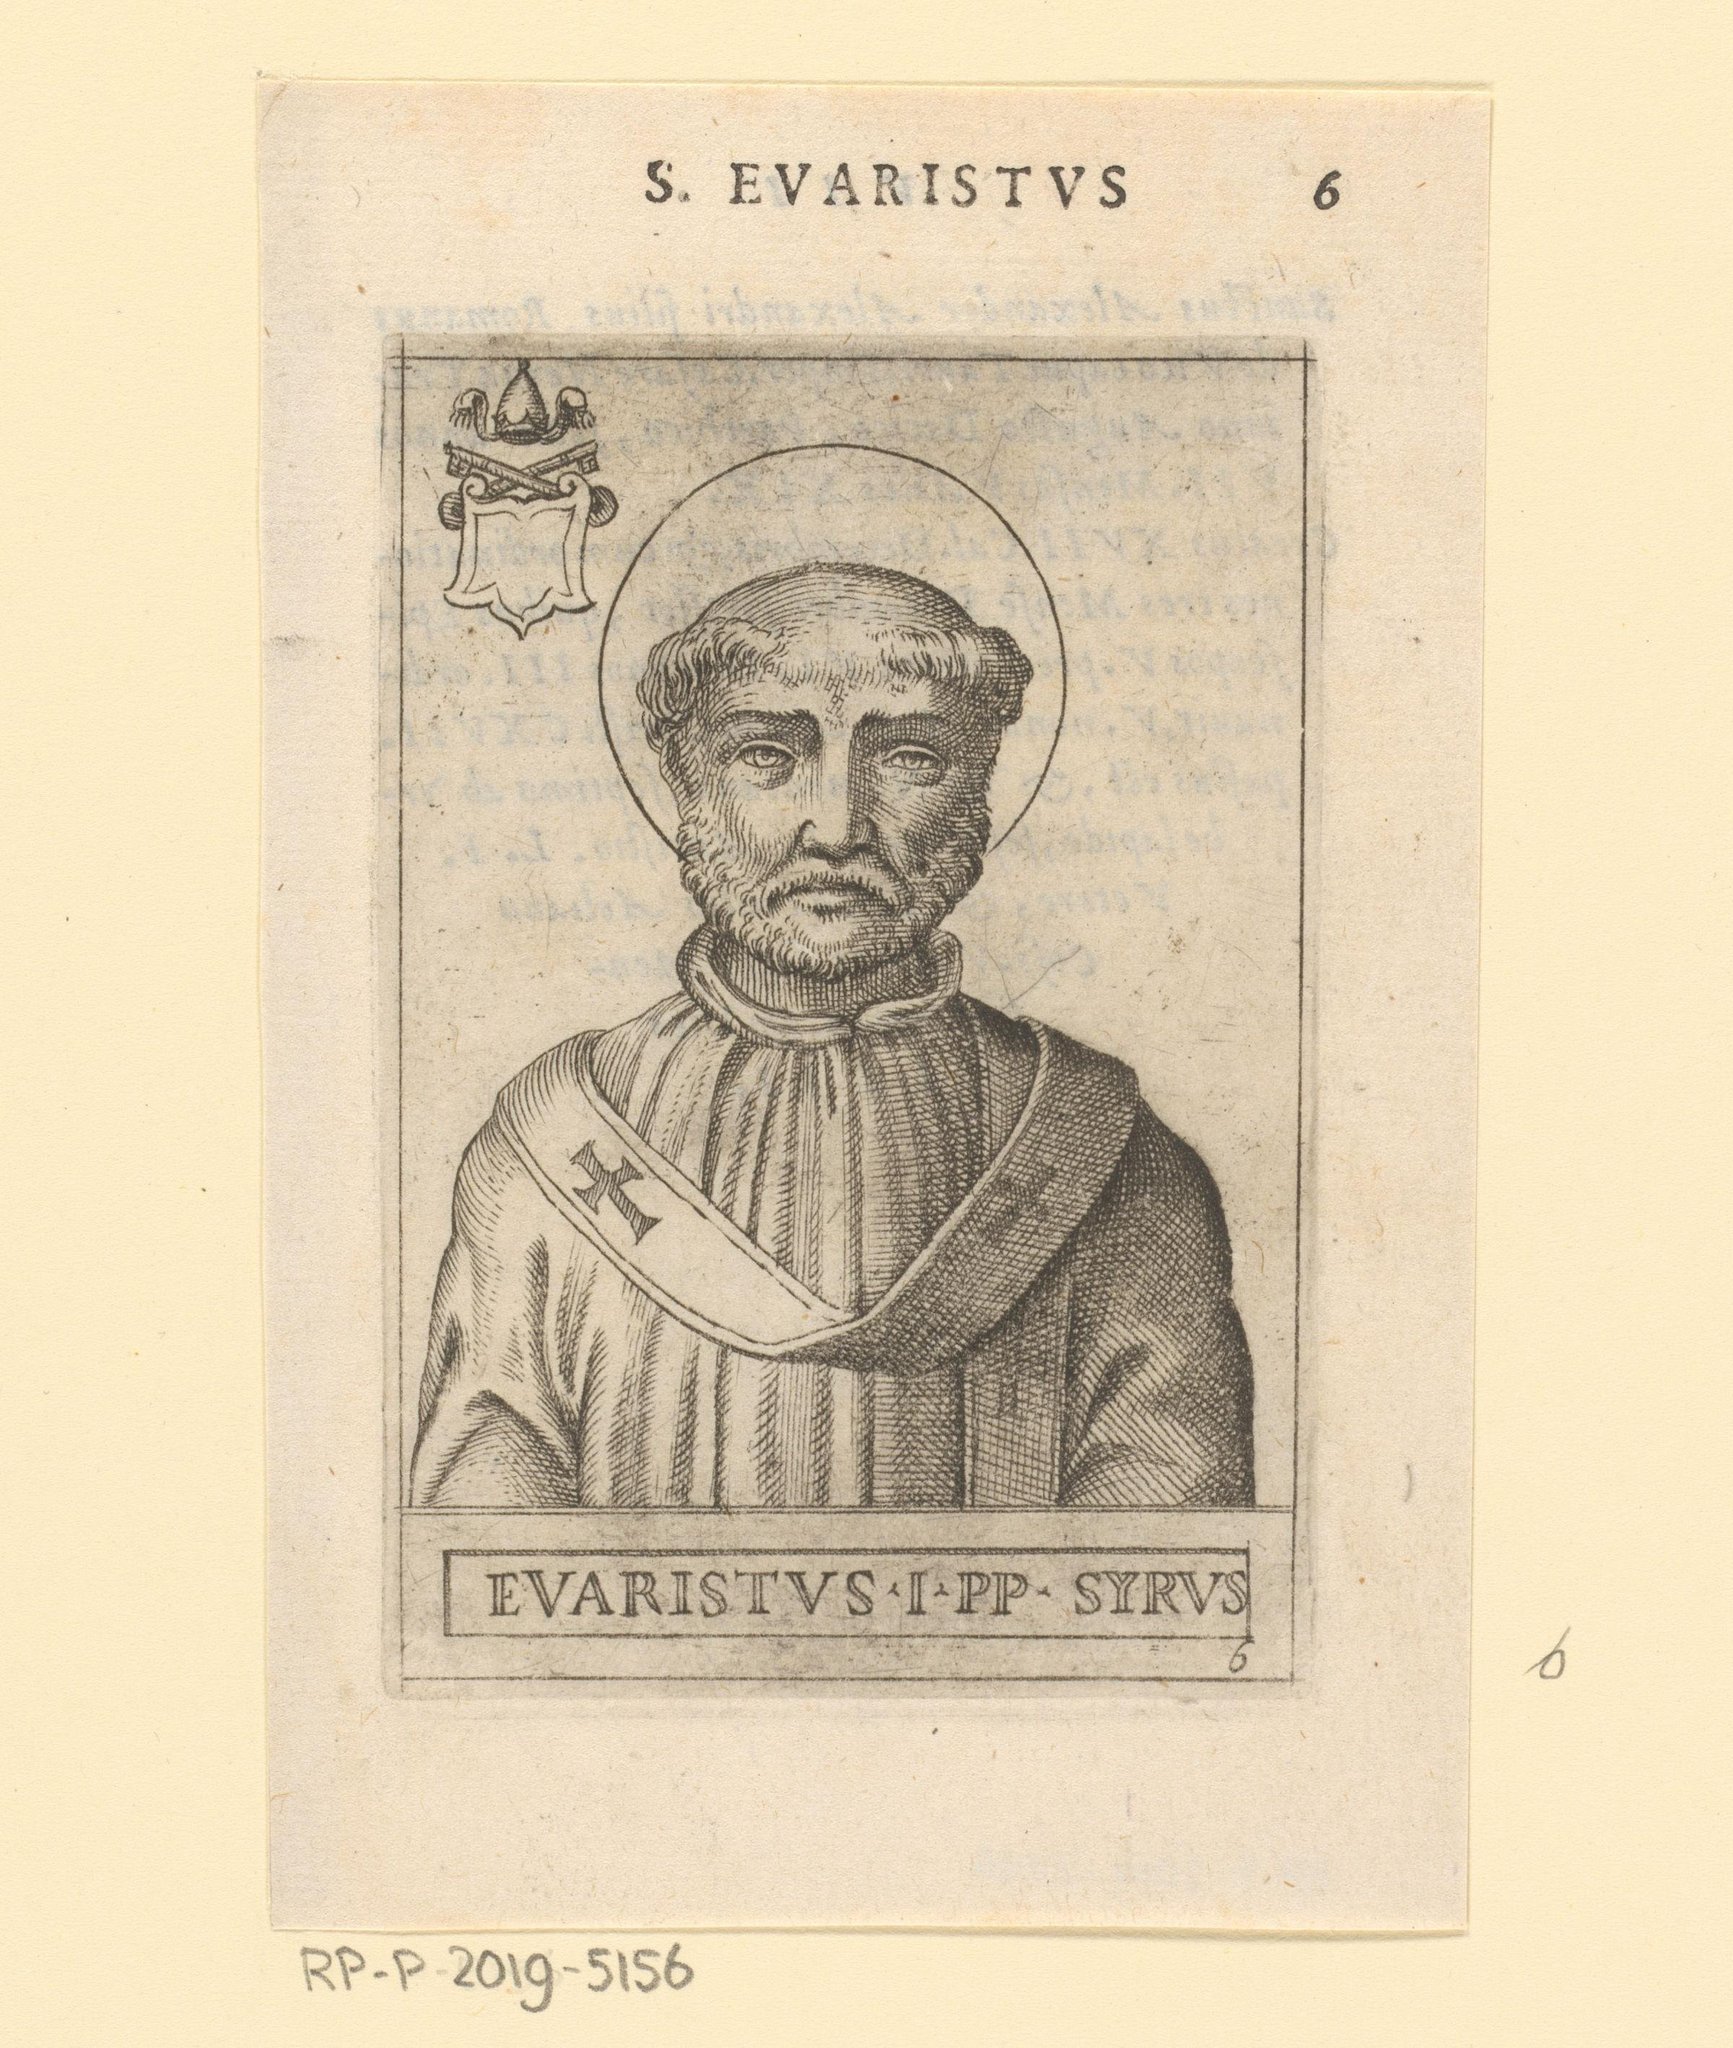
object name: print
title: Evaristus I PP Syrus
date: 1595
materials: paper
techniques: engraving, letterpress printing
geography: rome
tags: rome, historical persons, pope, armorial bearing, heraldry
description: Prent uit: Cavalieri, Giovanni Battista de'. Effigies pontificum romanorum cum eorum vitis (...). Rome: Bartolomeo Bonfadino, 1595. Prent voor het eerst verschenen in: Cavalieri, Giovanni Battista de'. Pontificum romanorum effigies (...). Rome: Domenico Basa en Francesco Zanetti, 1580. Prent ook gebruikt in latere publicaties.